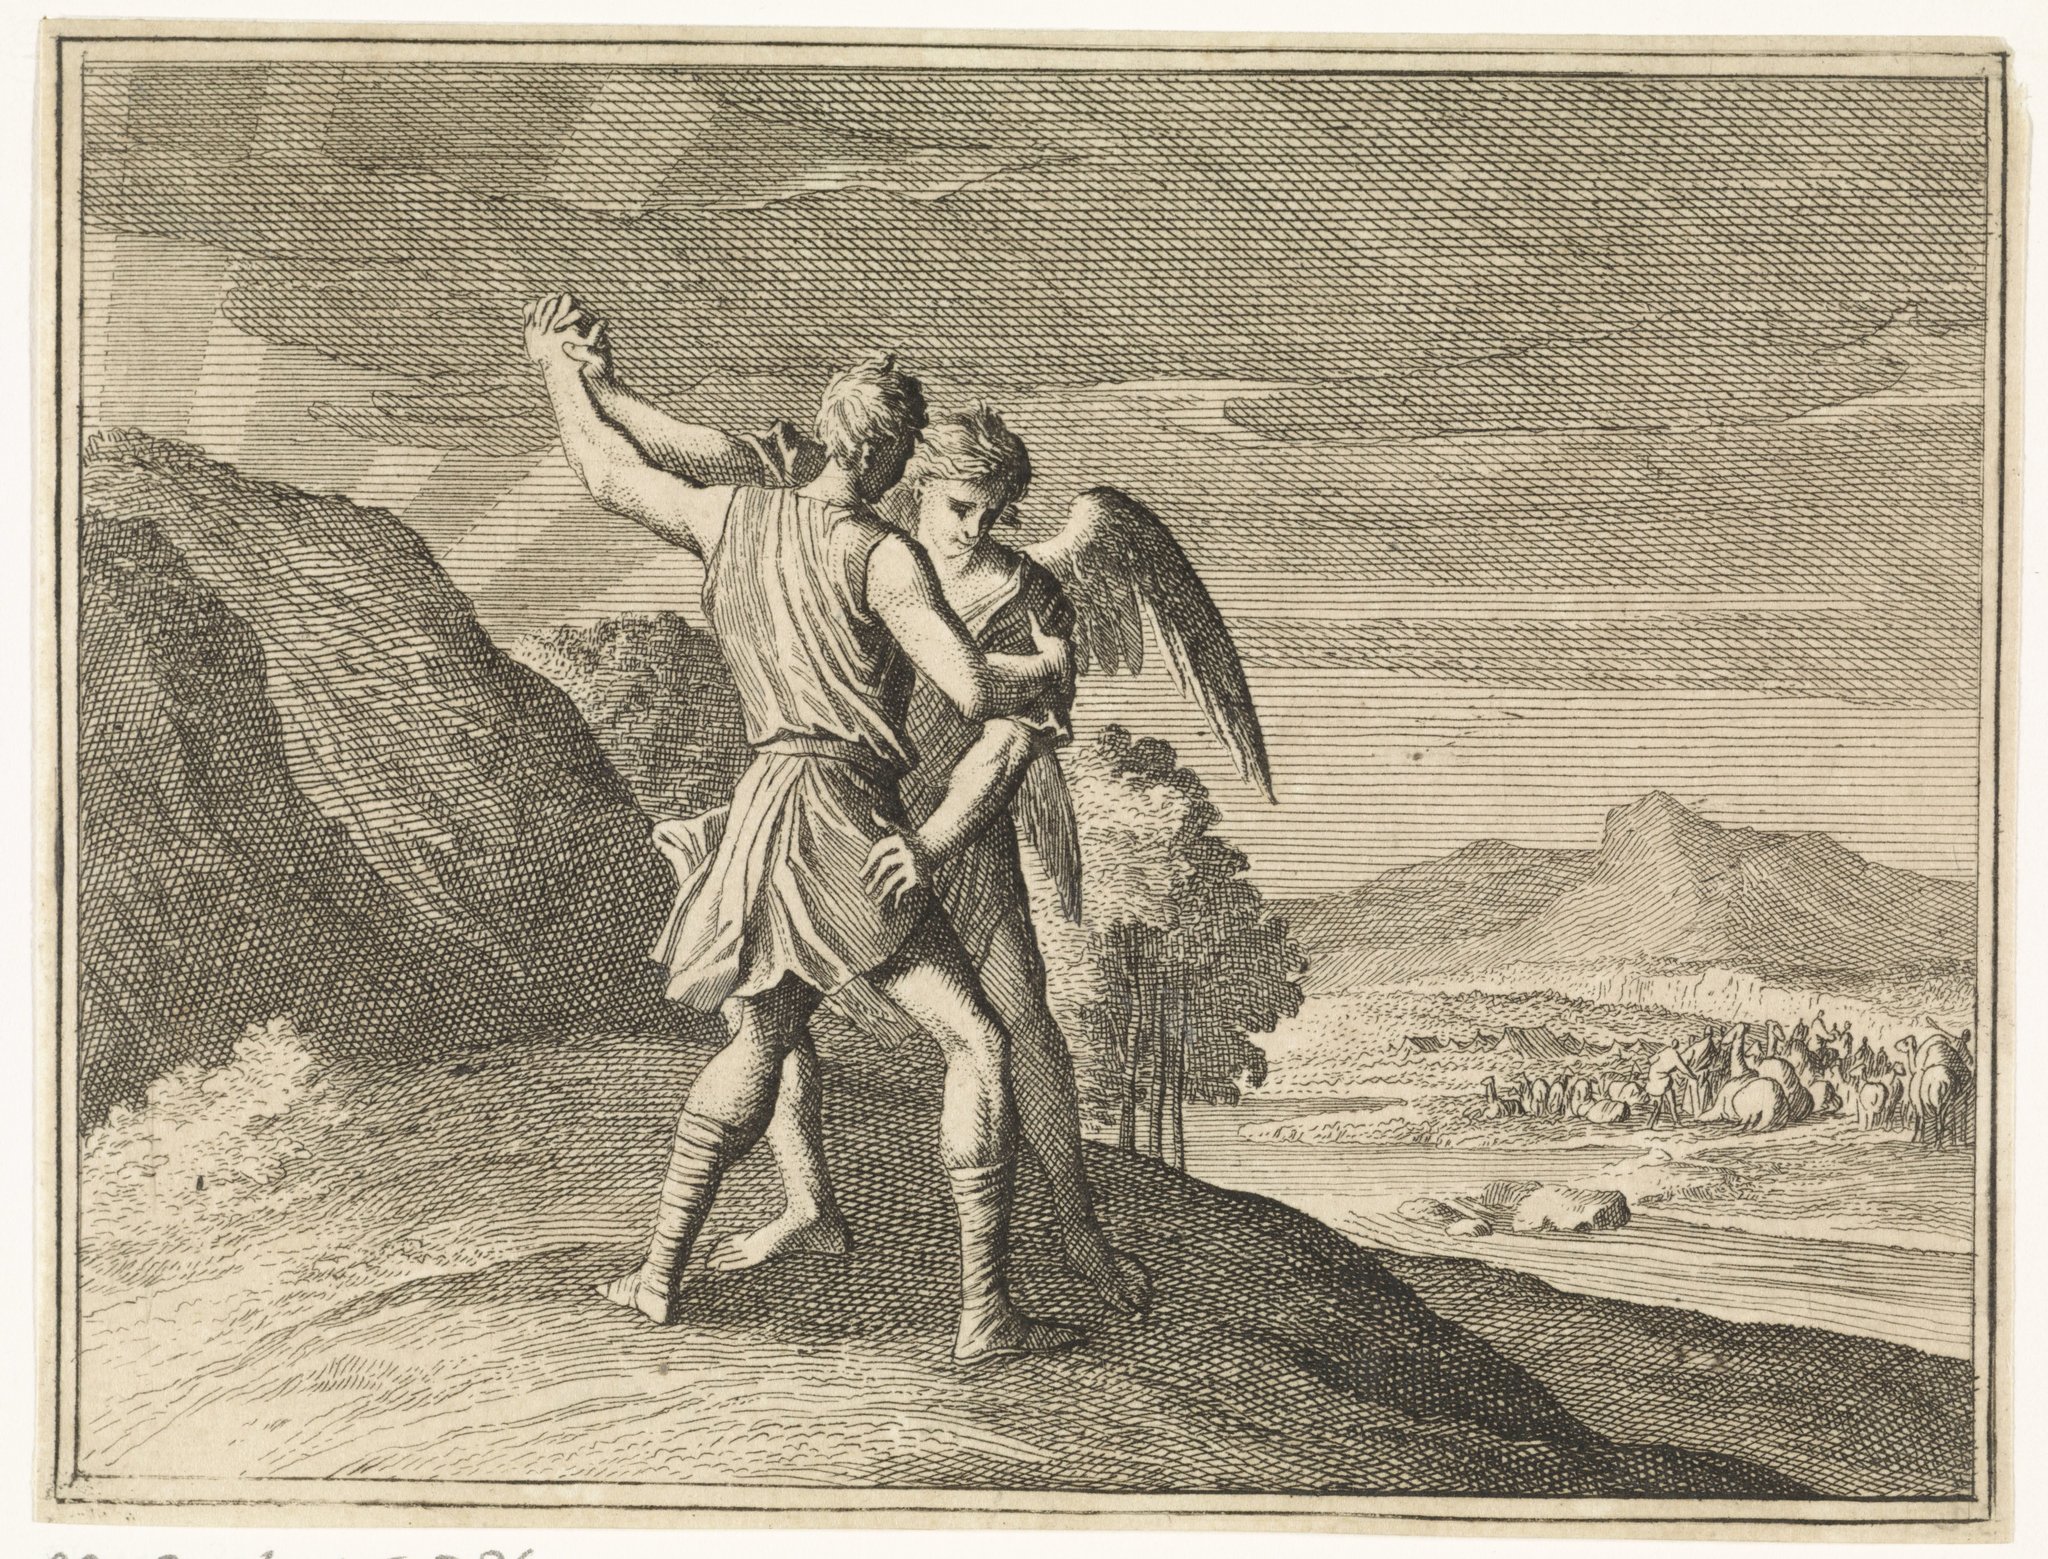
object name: print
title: Jakob worstelt met de engel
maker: caspar luyken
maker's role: draughtsman, print maker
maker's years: 1672-1708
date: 1712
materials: paper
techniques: etching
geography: amsterdam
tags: jacob wrestles with the angel (or man) till daybreak; jacob's thigh is put out of joint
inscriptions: number: ‘32’, collector's mark: Lugt 2228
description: Illustratie uit: Luyken, Jan. De schriftuurlyke geschiedenissen en gelykenissen van het Oude en Nieuwe Verbond, 2 delen. Amsterdam: Wed. Pieter Arentsz II en Cornelis van der Sys, 1712, dl. I.